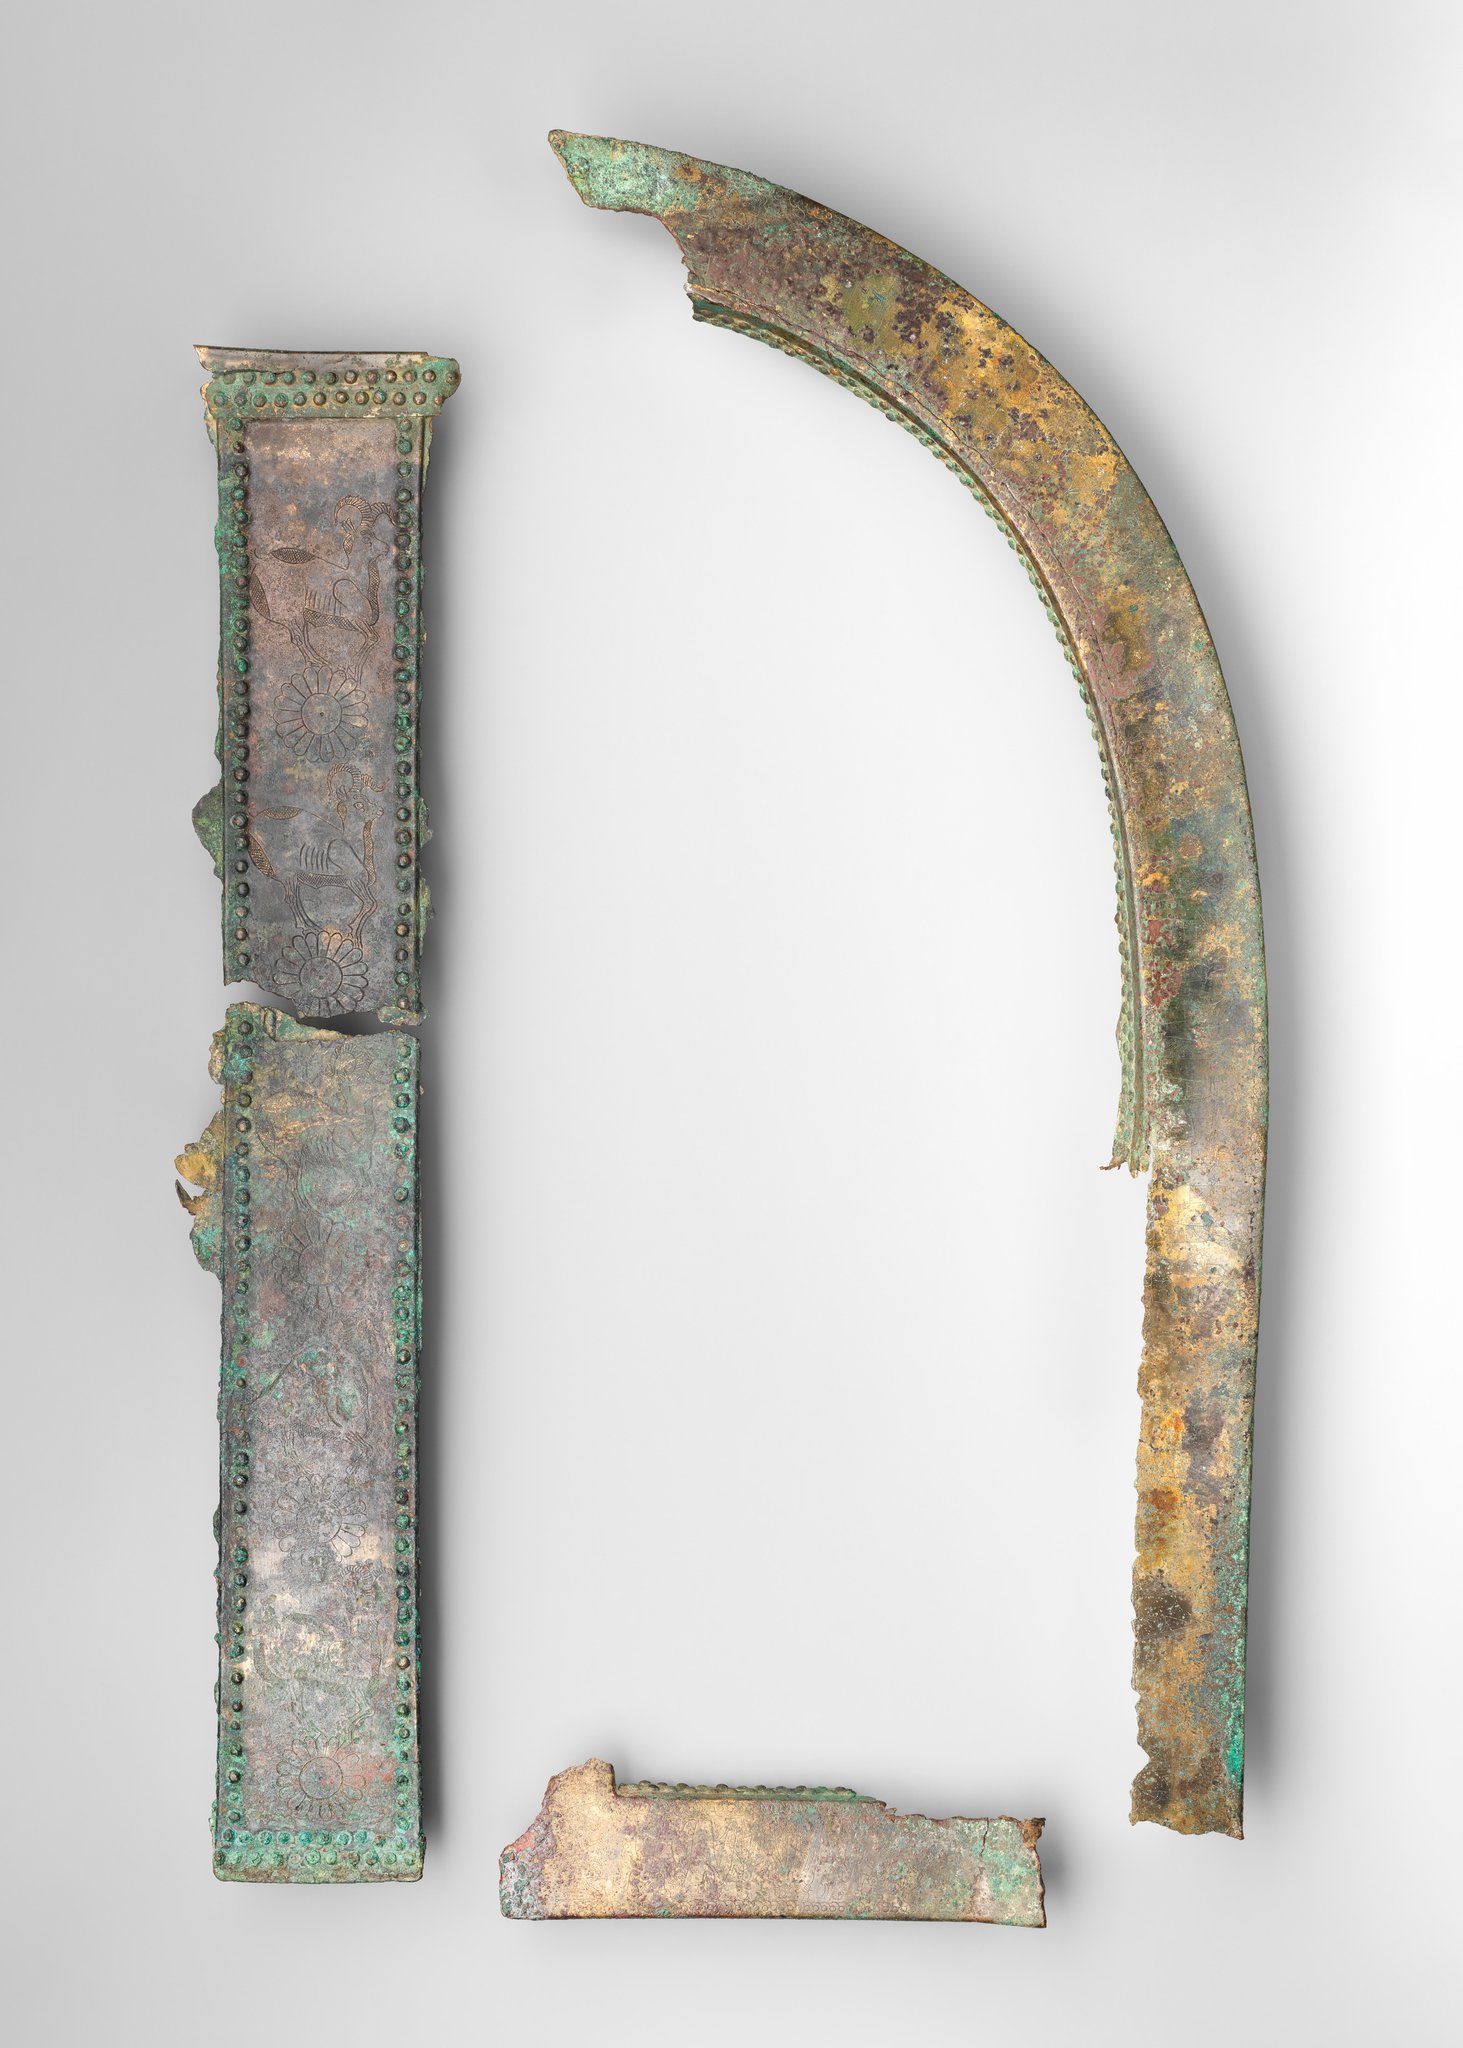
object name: coffin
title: Fragments of a coffin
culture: assyrian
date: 734-701 BCE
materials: bronze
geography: iran